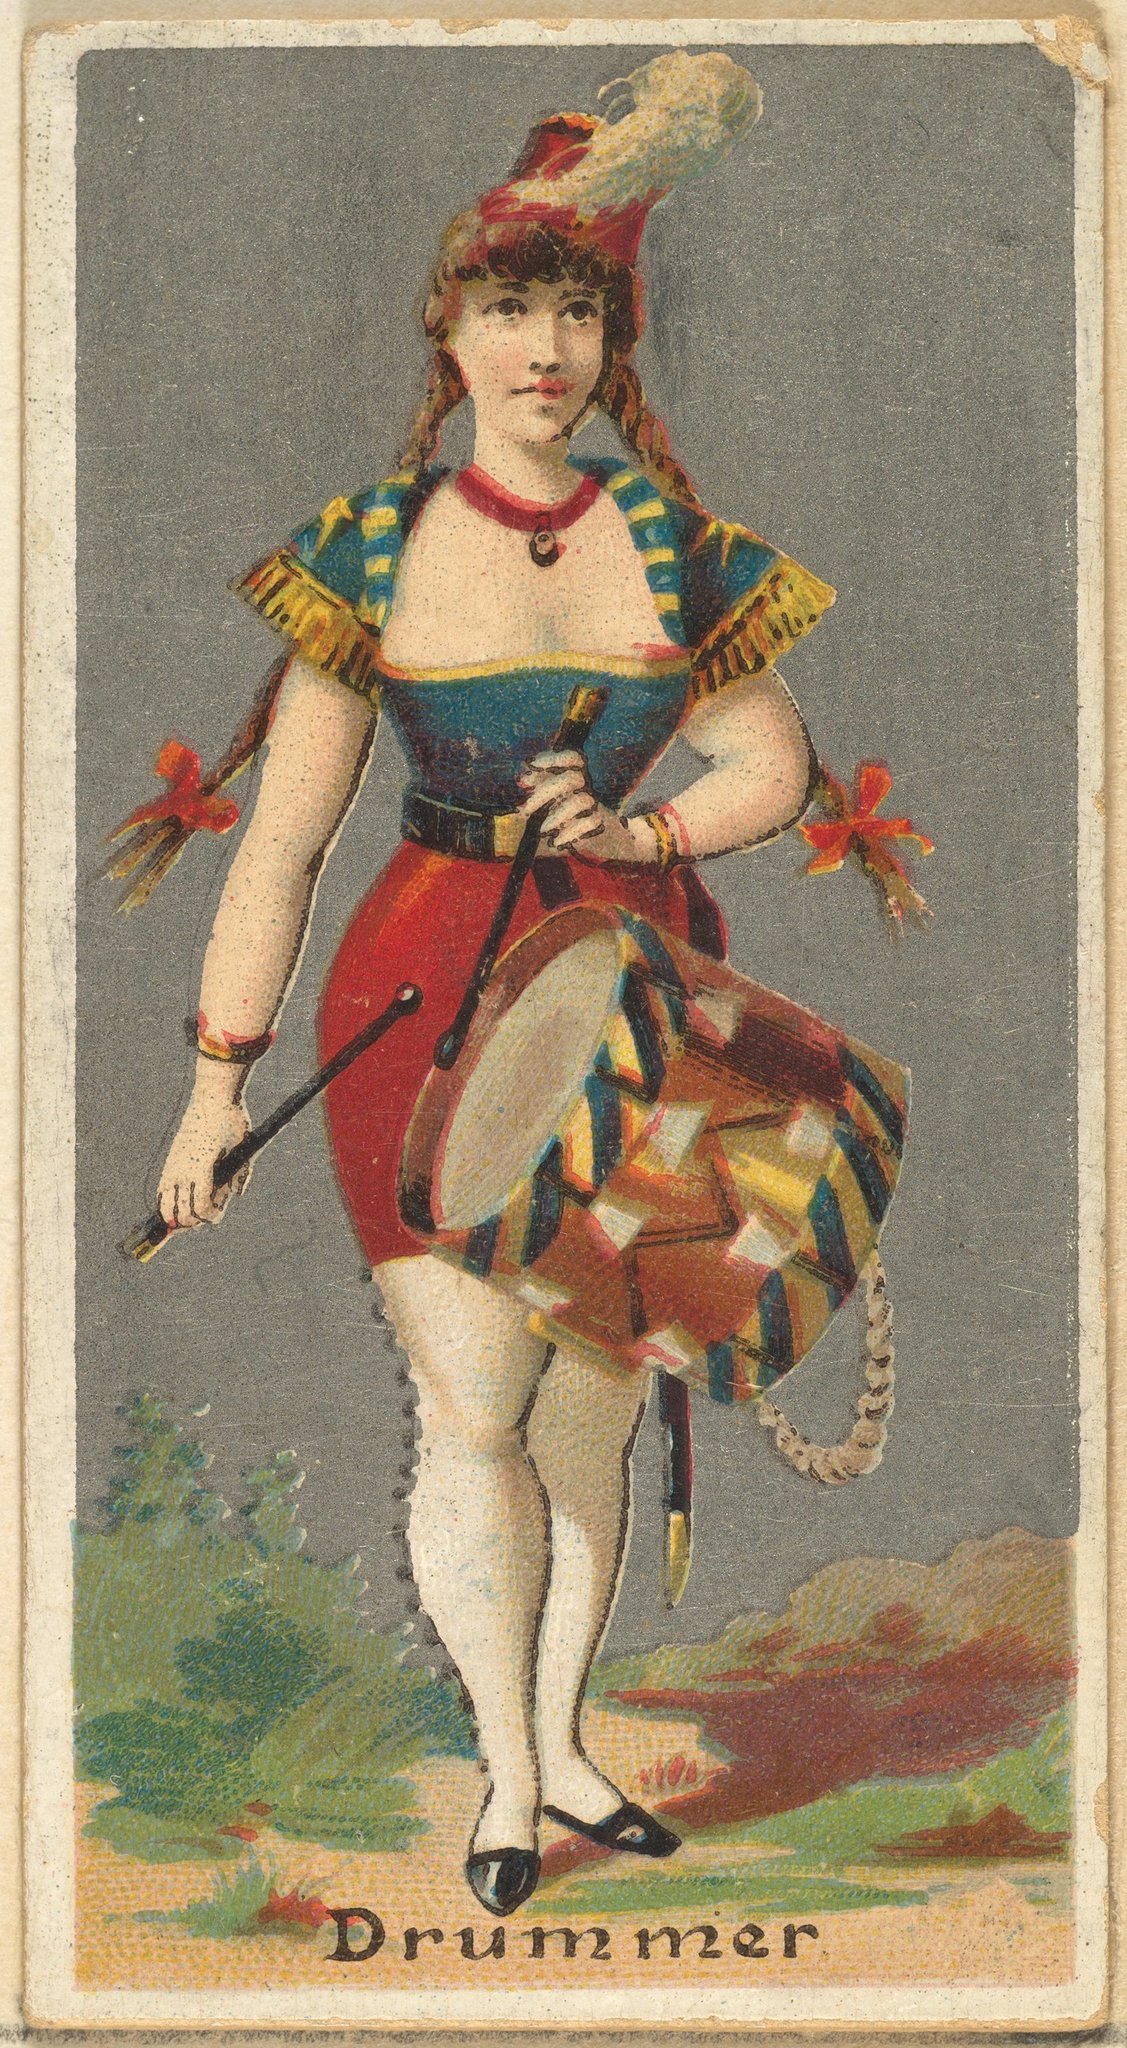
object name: print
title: Drummer, from the Occupations for Women series (N166) for Old Judge and Dogs Head Cigarettes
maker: goodwin & company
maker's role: publisher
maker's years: 1850-1950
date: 1887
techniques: color lithograph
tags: women,drums,musicians